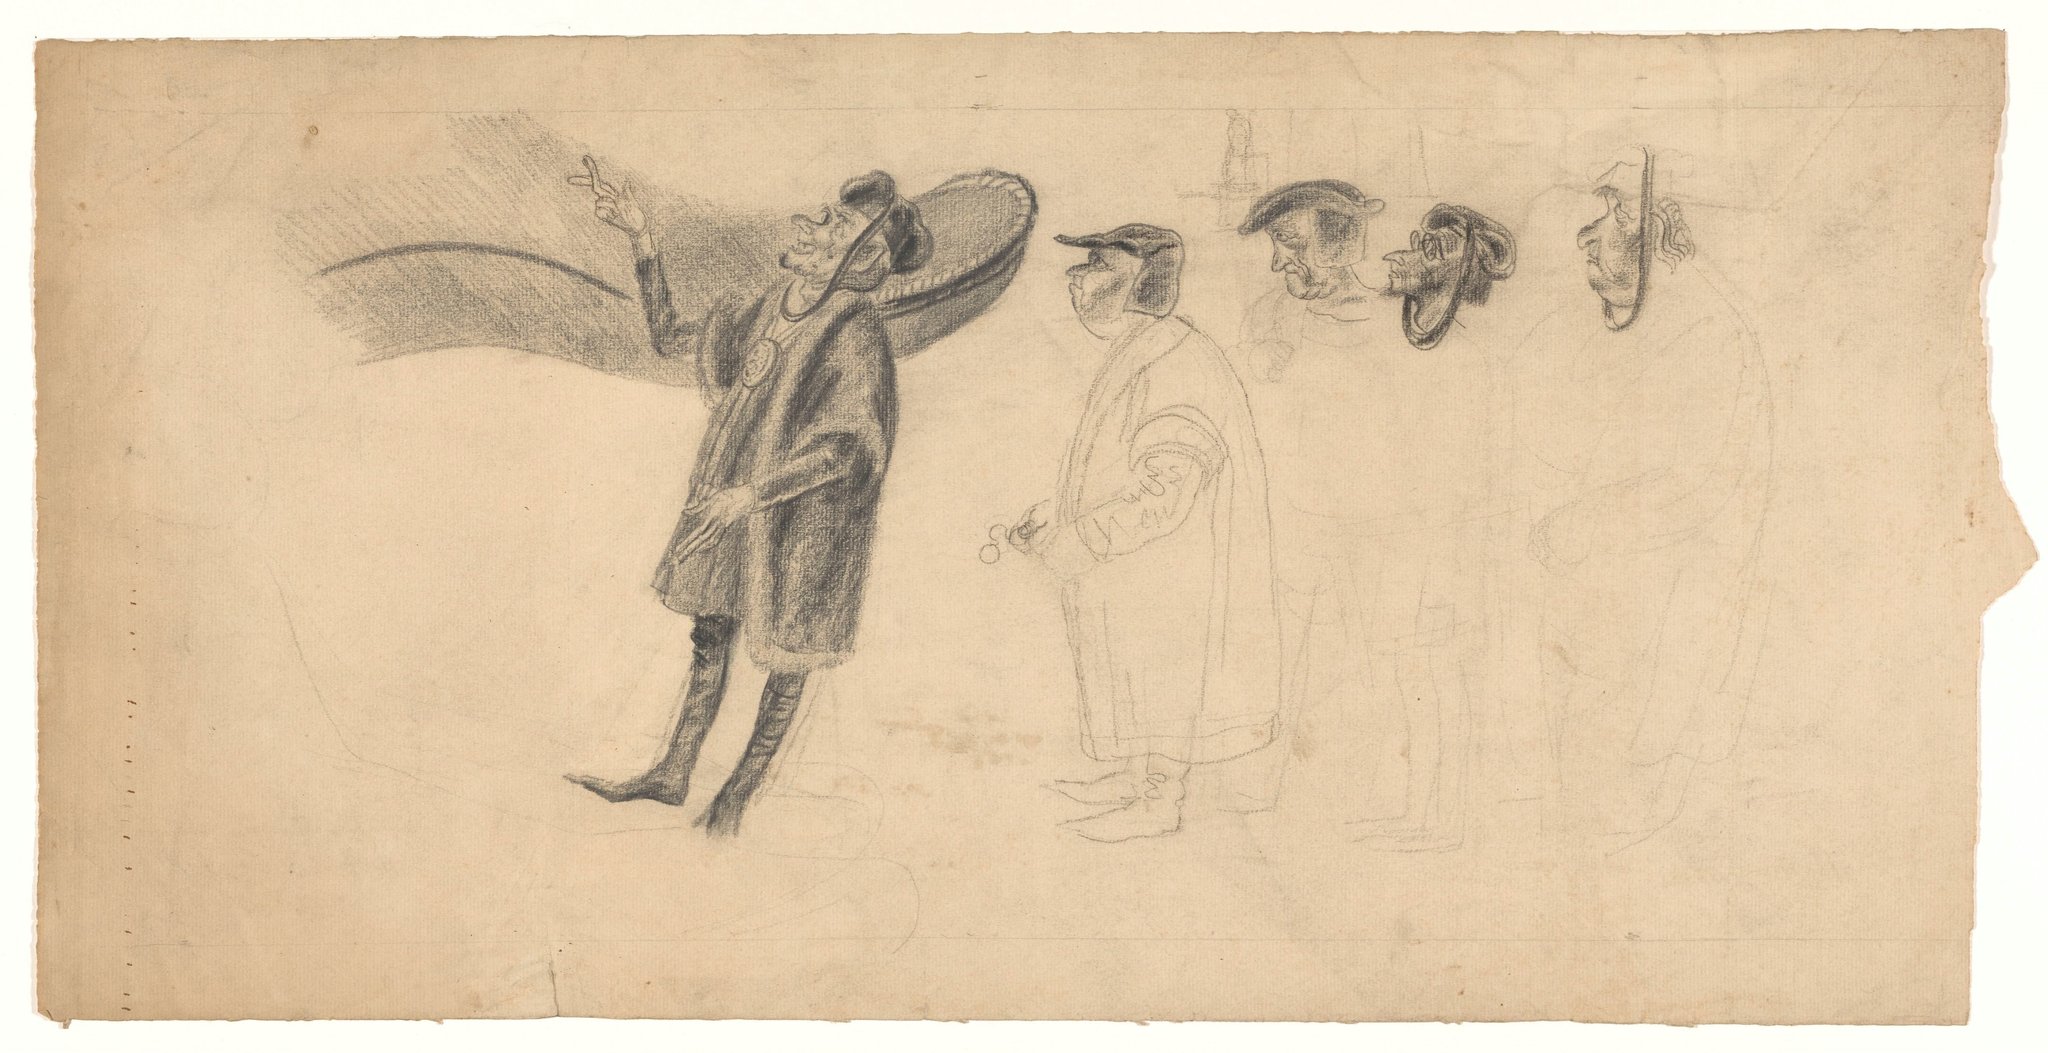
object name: drawing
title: Vijf mannen op een rij bij de voet van een reus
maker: henk henriët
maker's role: draughtsman, print maker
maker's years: 1903-1945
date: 1936-1940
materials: chalk, paper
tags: standing figure, head-gear: hat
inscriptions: collector's mark: Lugt 2228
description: Deze tekening is mogelijk een ontwerp voor een illustratie bij het boek 'Gargantua en Pantagruel' van François Rabelais.